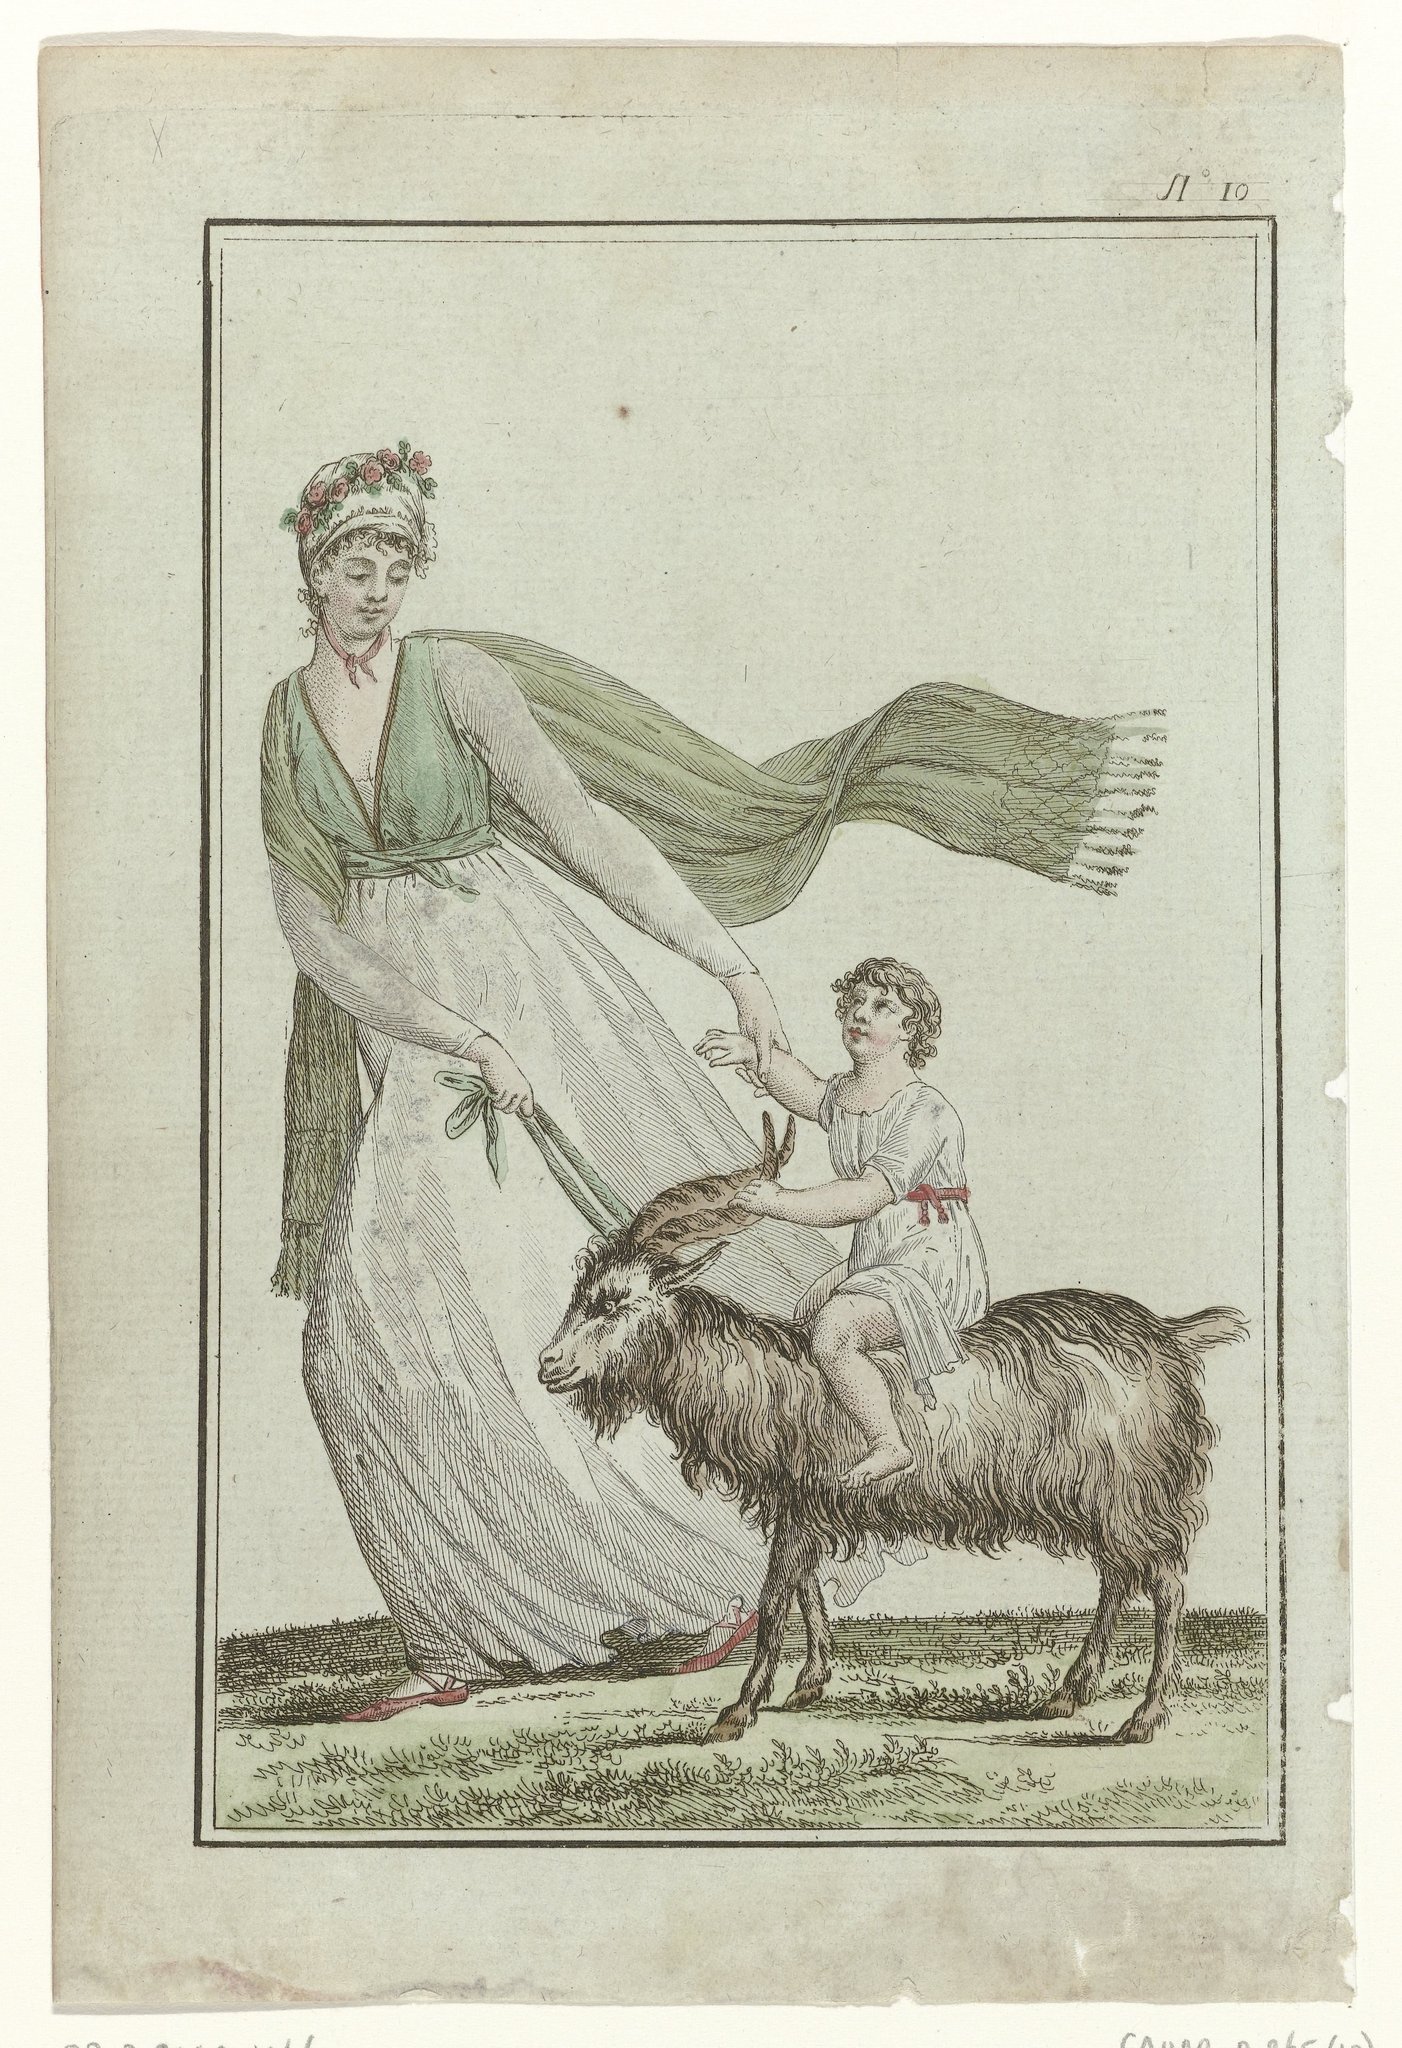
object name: fashion print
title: Tableau Général du Goût, An 1, No. 10 (21 nov. 1798): Jeune élégante jouant avec son enfant (...)..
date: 1798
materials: paper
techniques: etching, hand coloring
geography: paris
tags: head-gear: cap (+ women's clothes), fashion plates, shoes, sandals (+ women's clothes), dress, gown (+ women's clothes), he-goat, billy-goat, mother and child(ren), woman and child(ren) (family group)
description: Jonge elegante vrouw met aan de hand een kind, zittend op een bok. Zij draagt een japon met lange mouwen, het lijfje(?) in contrasterende kleur. Accessoires: muts versierd met bloemen, lange sjaal met aan de uiteinden franjes, platte schoenen met puntige neuzen en bandjes. Volgens de begeleidende tekst speelt de vrouw met haar kind op de grasvelden van de Champs-Élysées. De prent maakt deel uit van een reeks van 20 modeprenten, uitgegeven door Gide, Parijs, An VII, 1797- 1799.